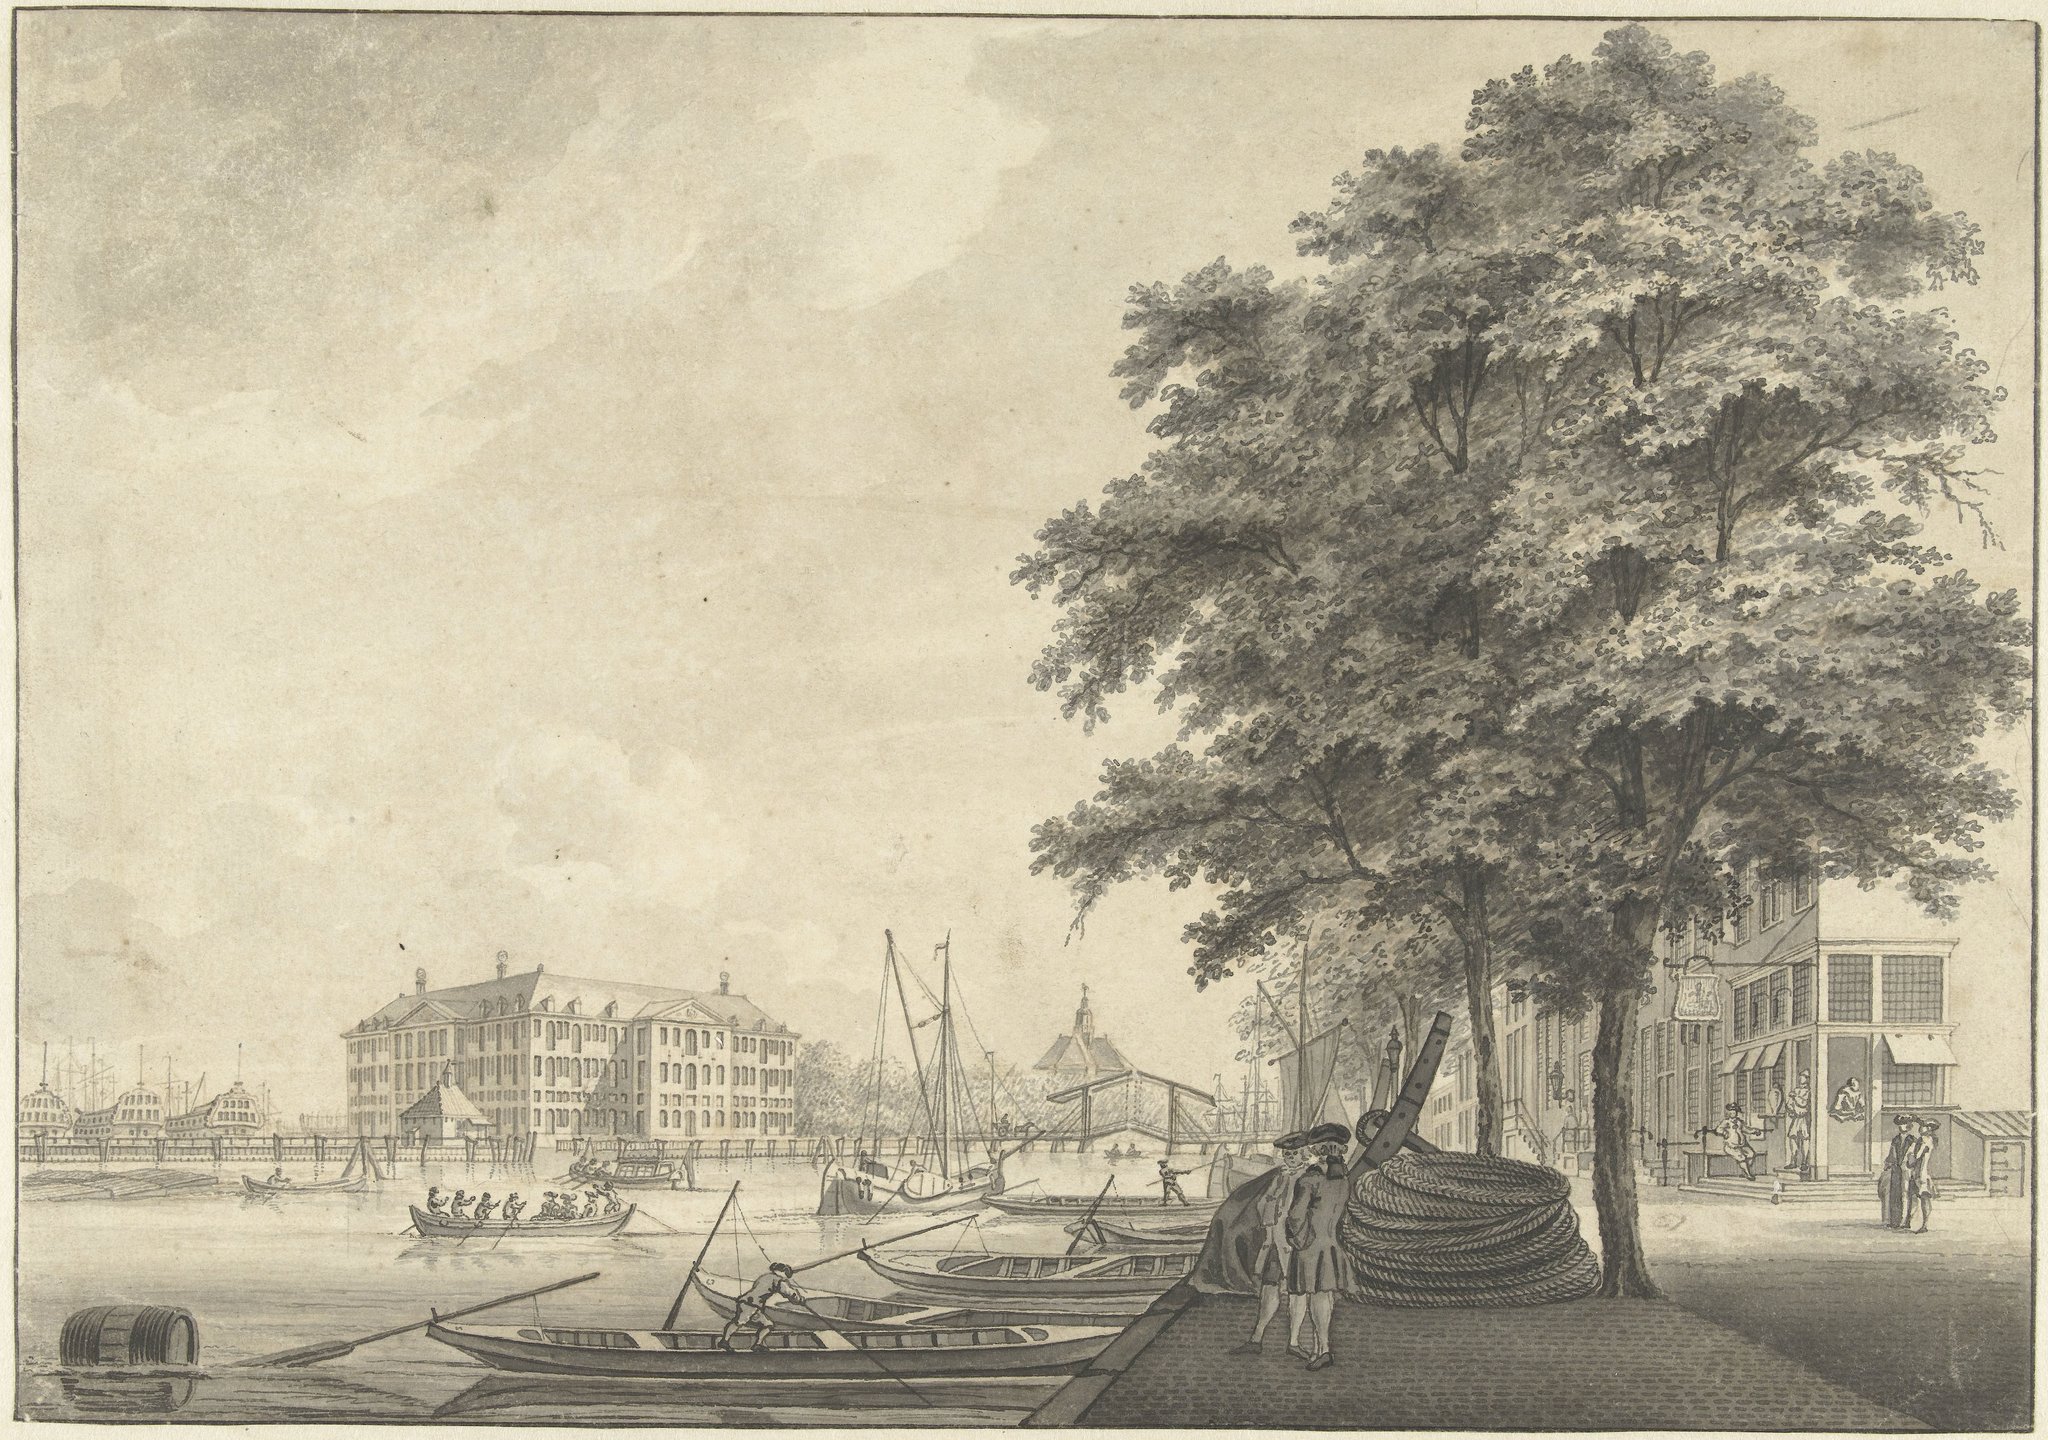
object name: drawing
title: Gezicht op 's Lands Zeemagazijn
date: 1768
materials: ink, paper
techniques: brush, pen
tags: city-view, and landscape with man-made constructions, amsterdam